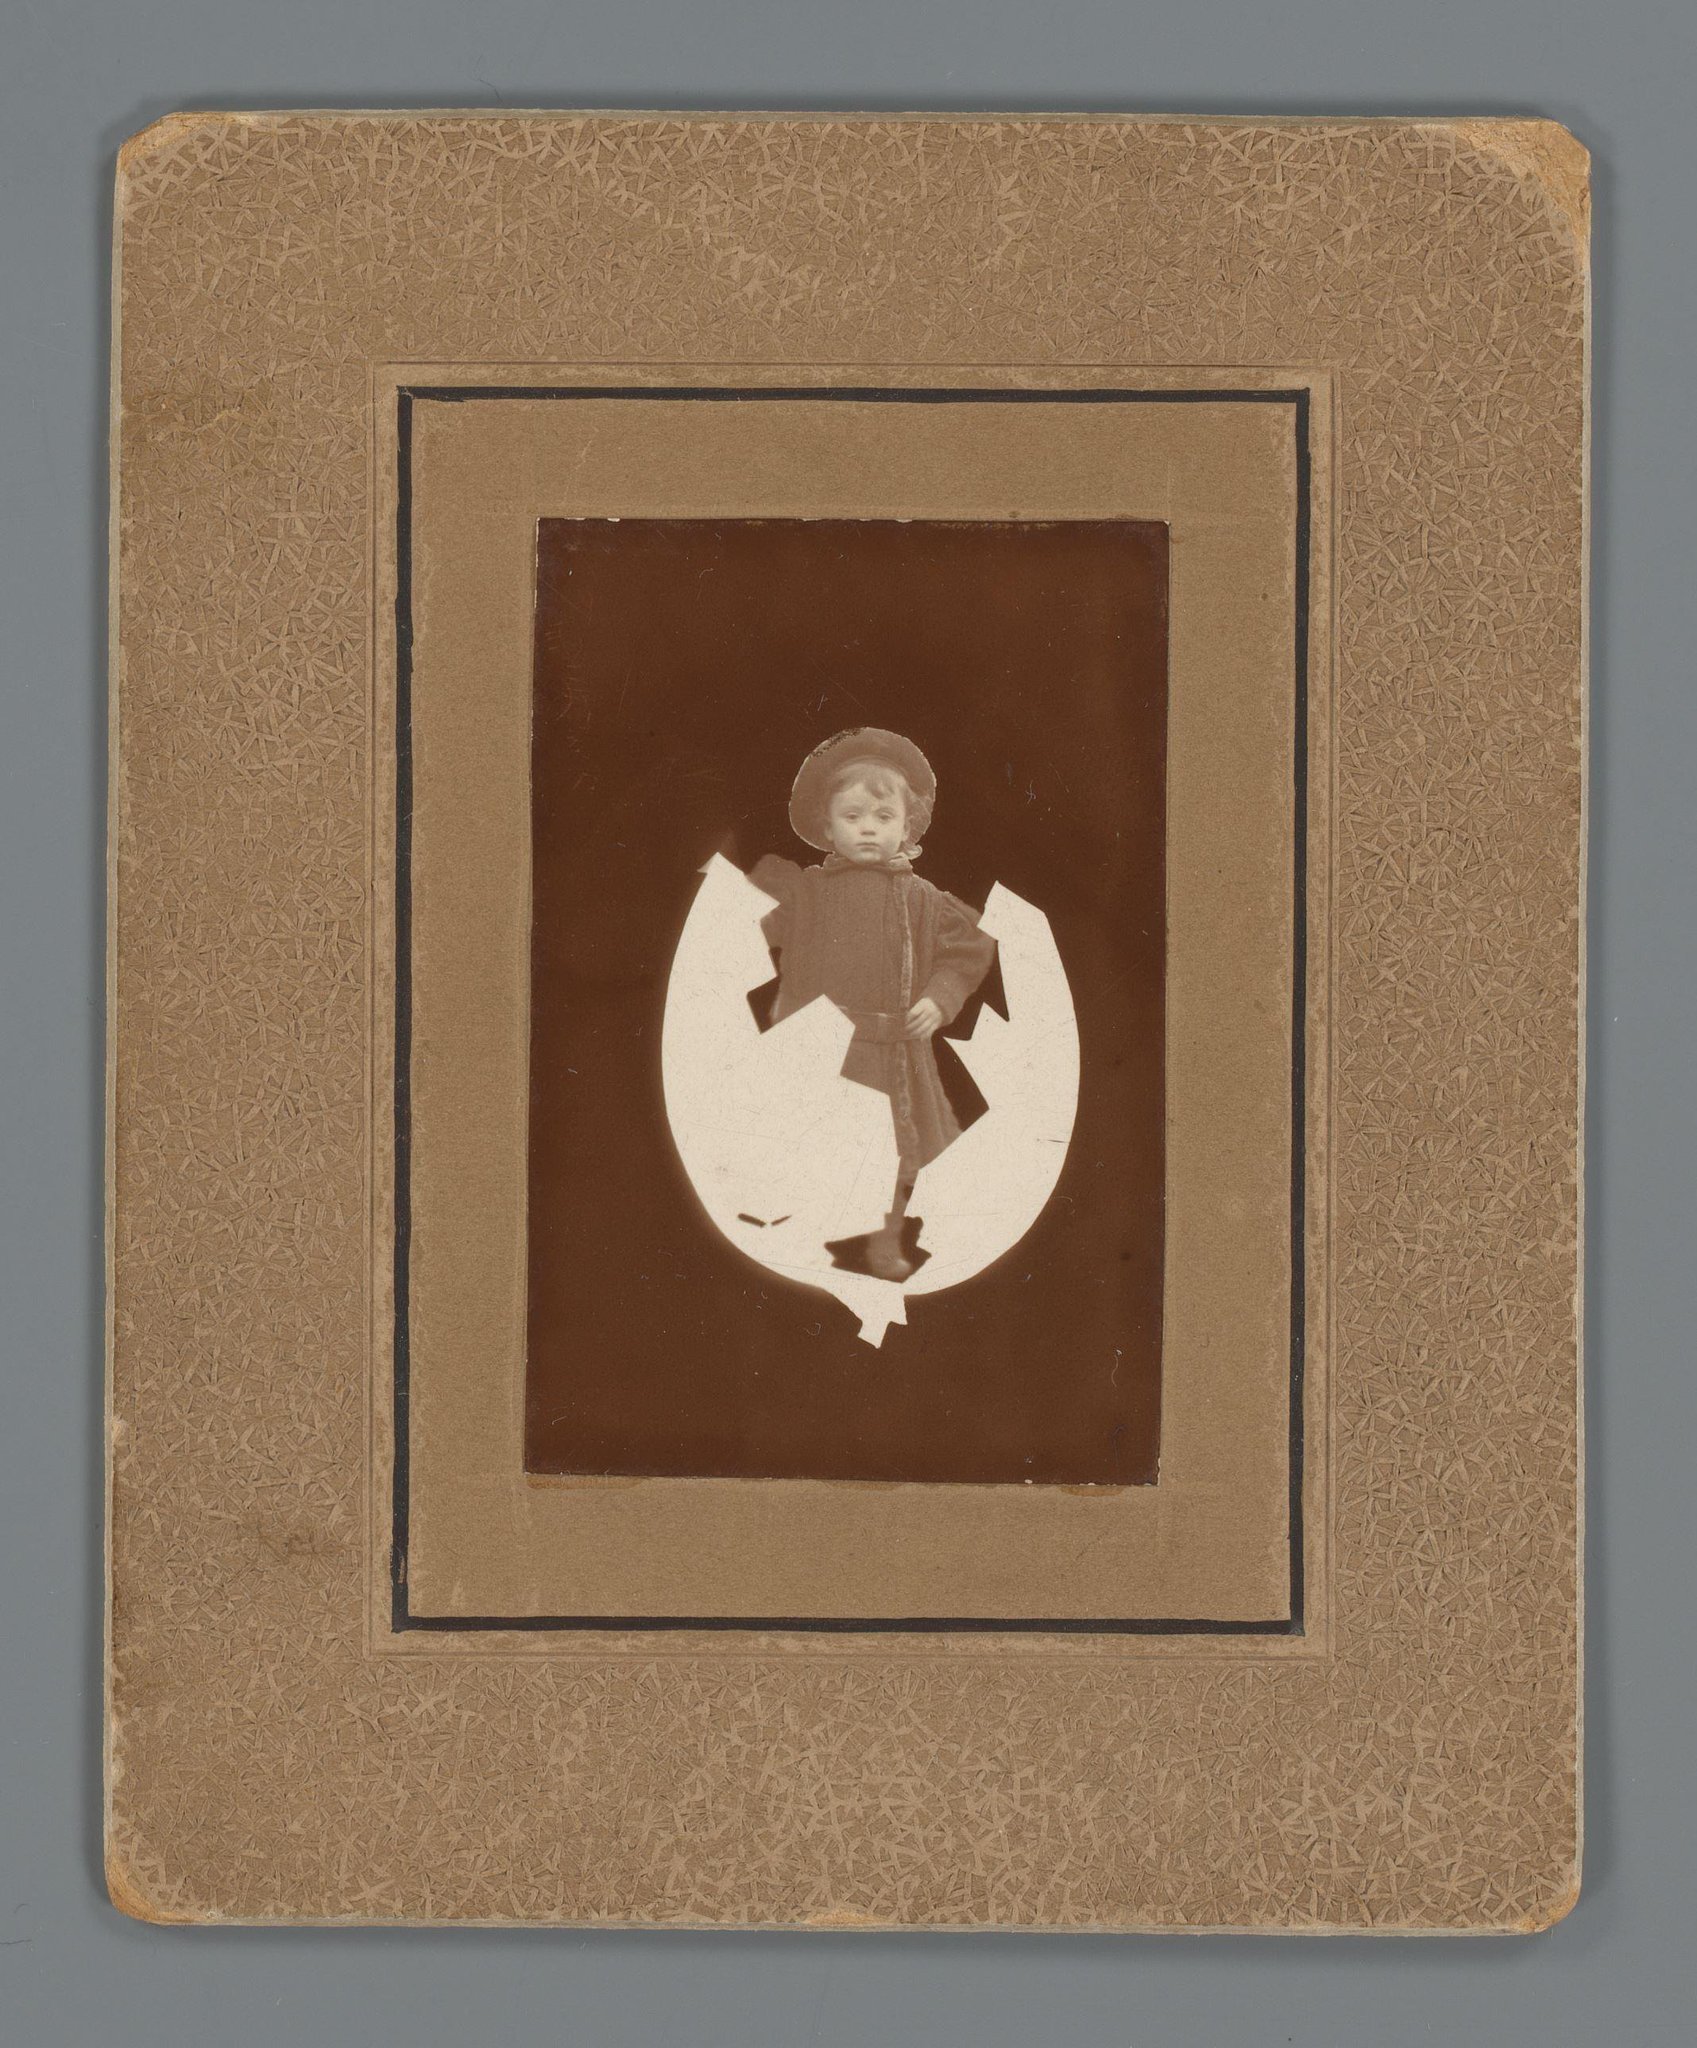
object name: photograph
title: Fotomontage van een kind dat uit een ei komt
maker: Anonymous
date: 1930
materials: cardboard, photographic support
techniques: gelatin silver print